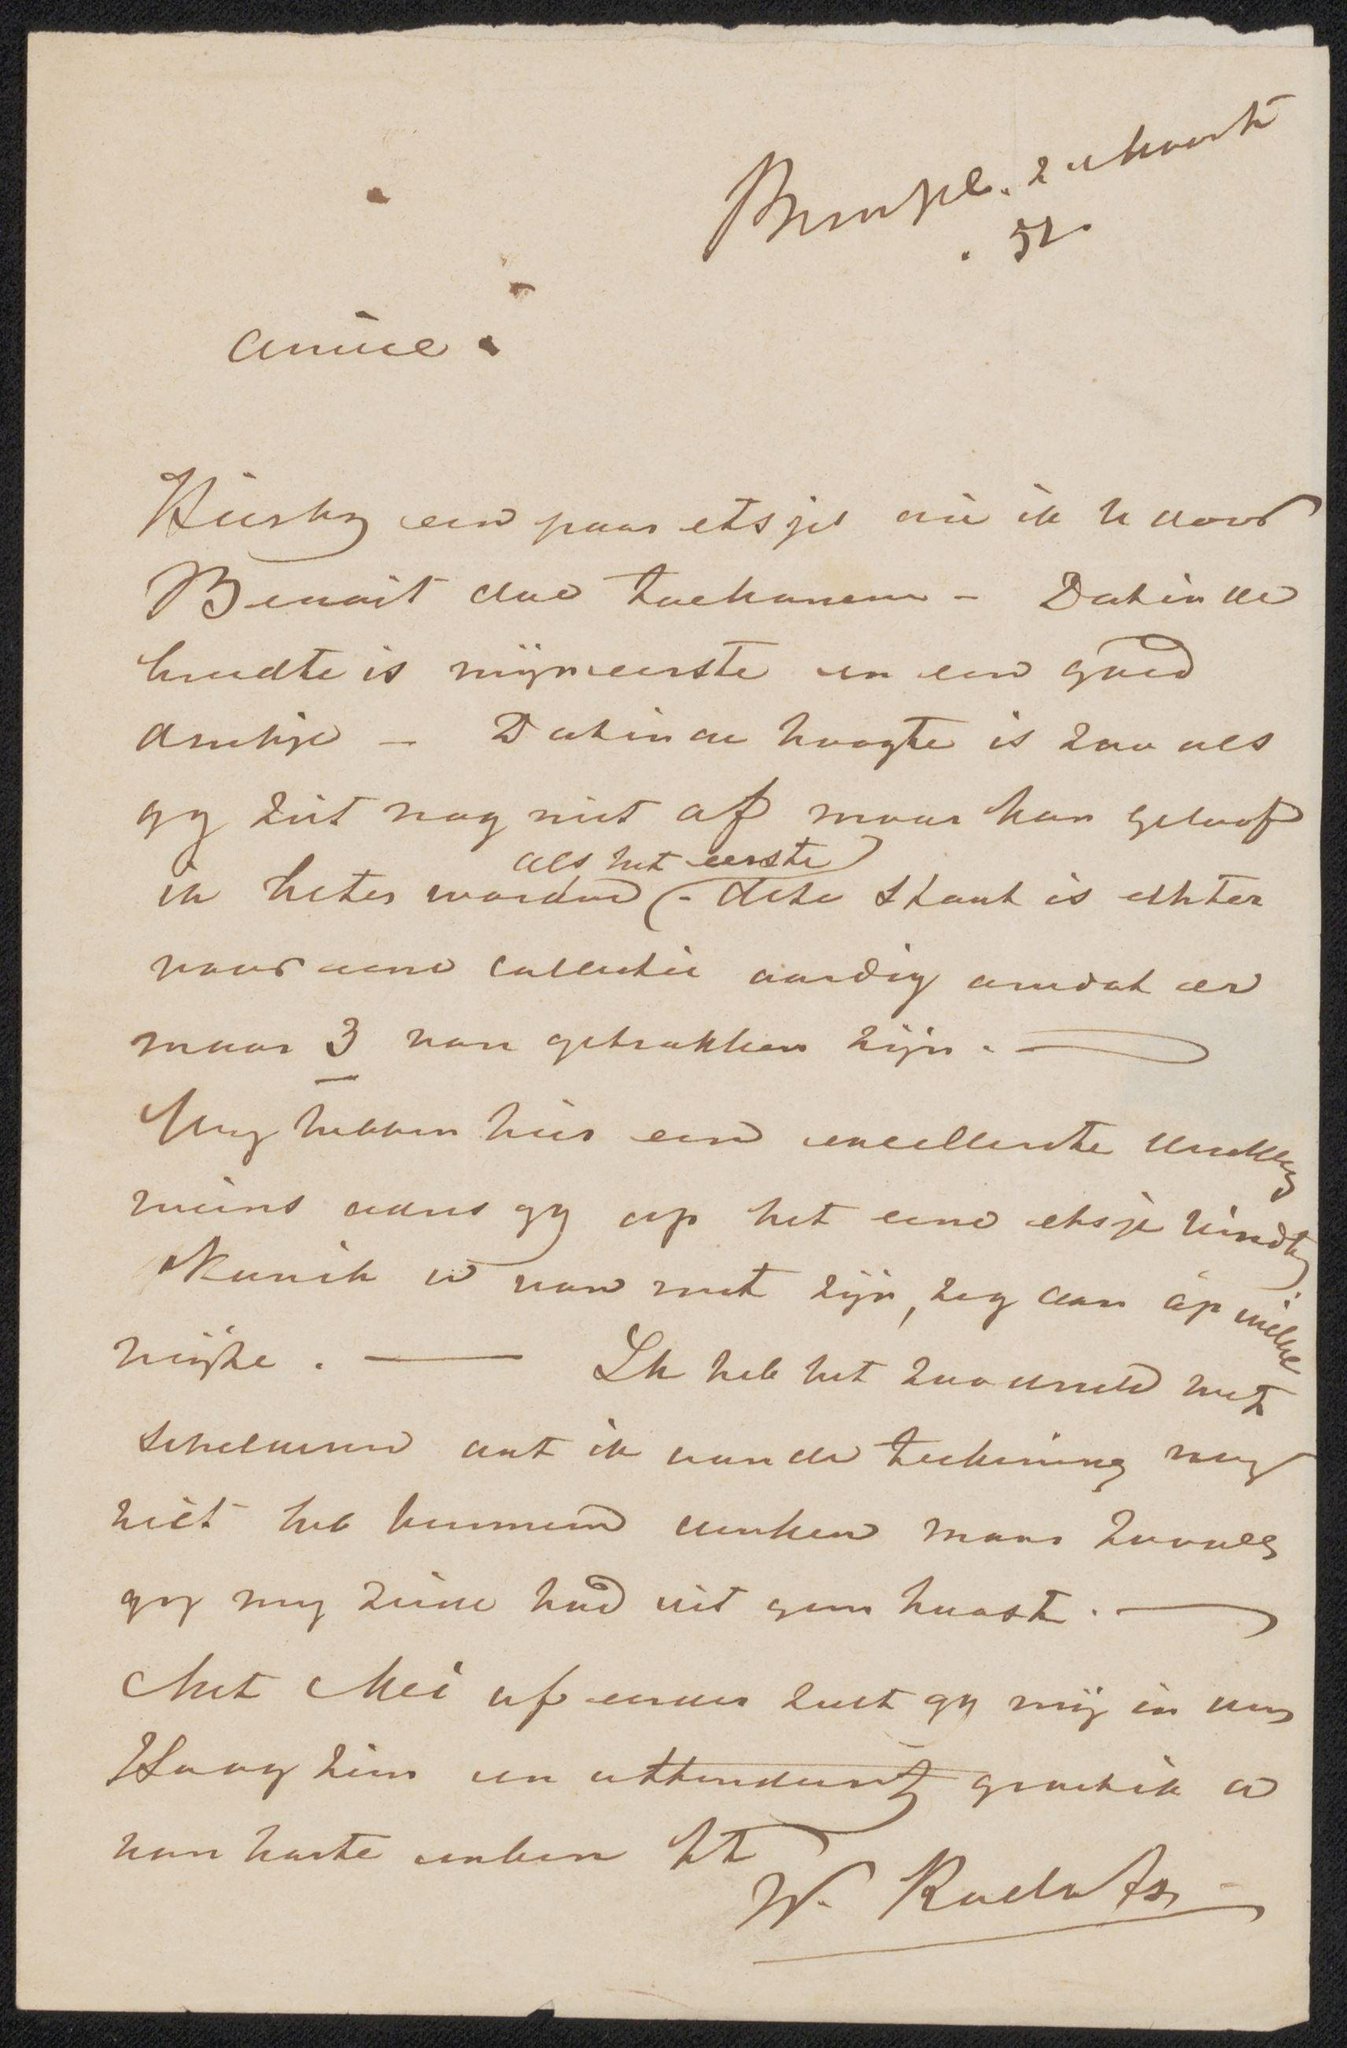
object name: letter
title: Brief aan Johan Hendrik Weissenbruch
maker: albert roelofs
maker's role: print maker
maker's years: 1877-1920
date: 1852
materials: ink, paper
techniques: pen, writing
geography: brussels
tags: draughtsman, johan hendrik weissenbruch, drawing, the graphic arts